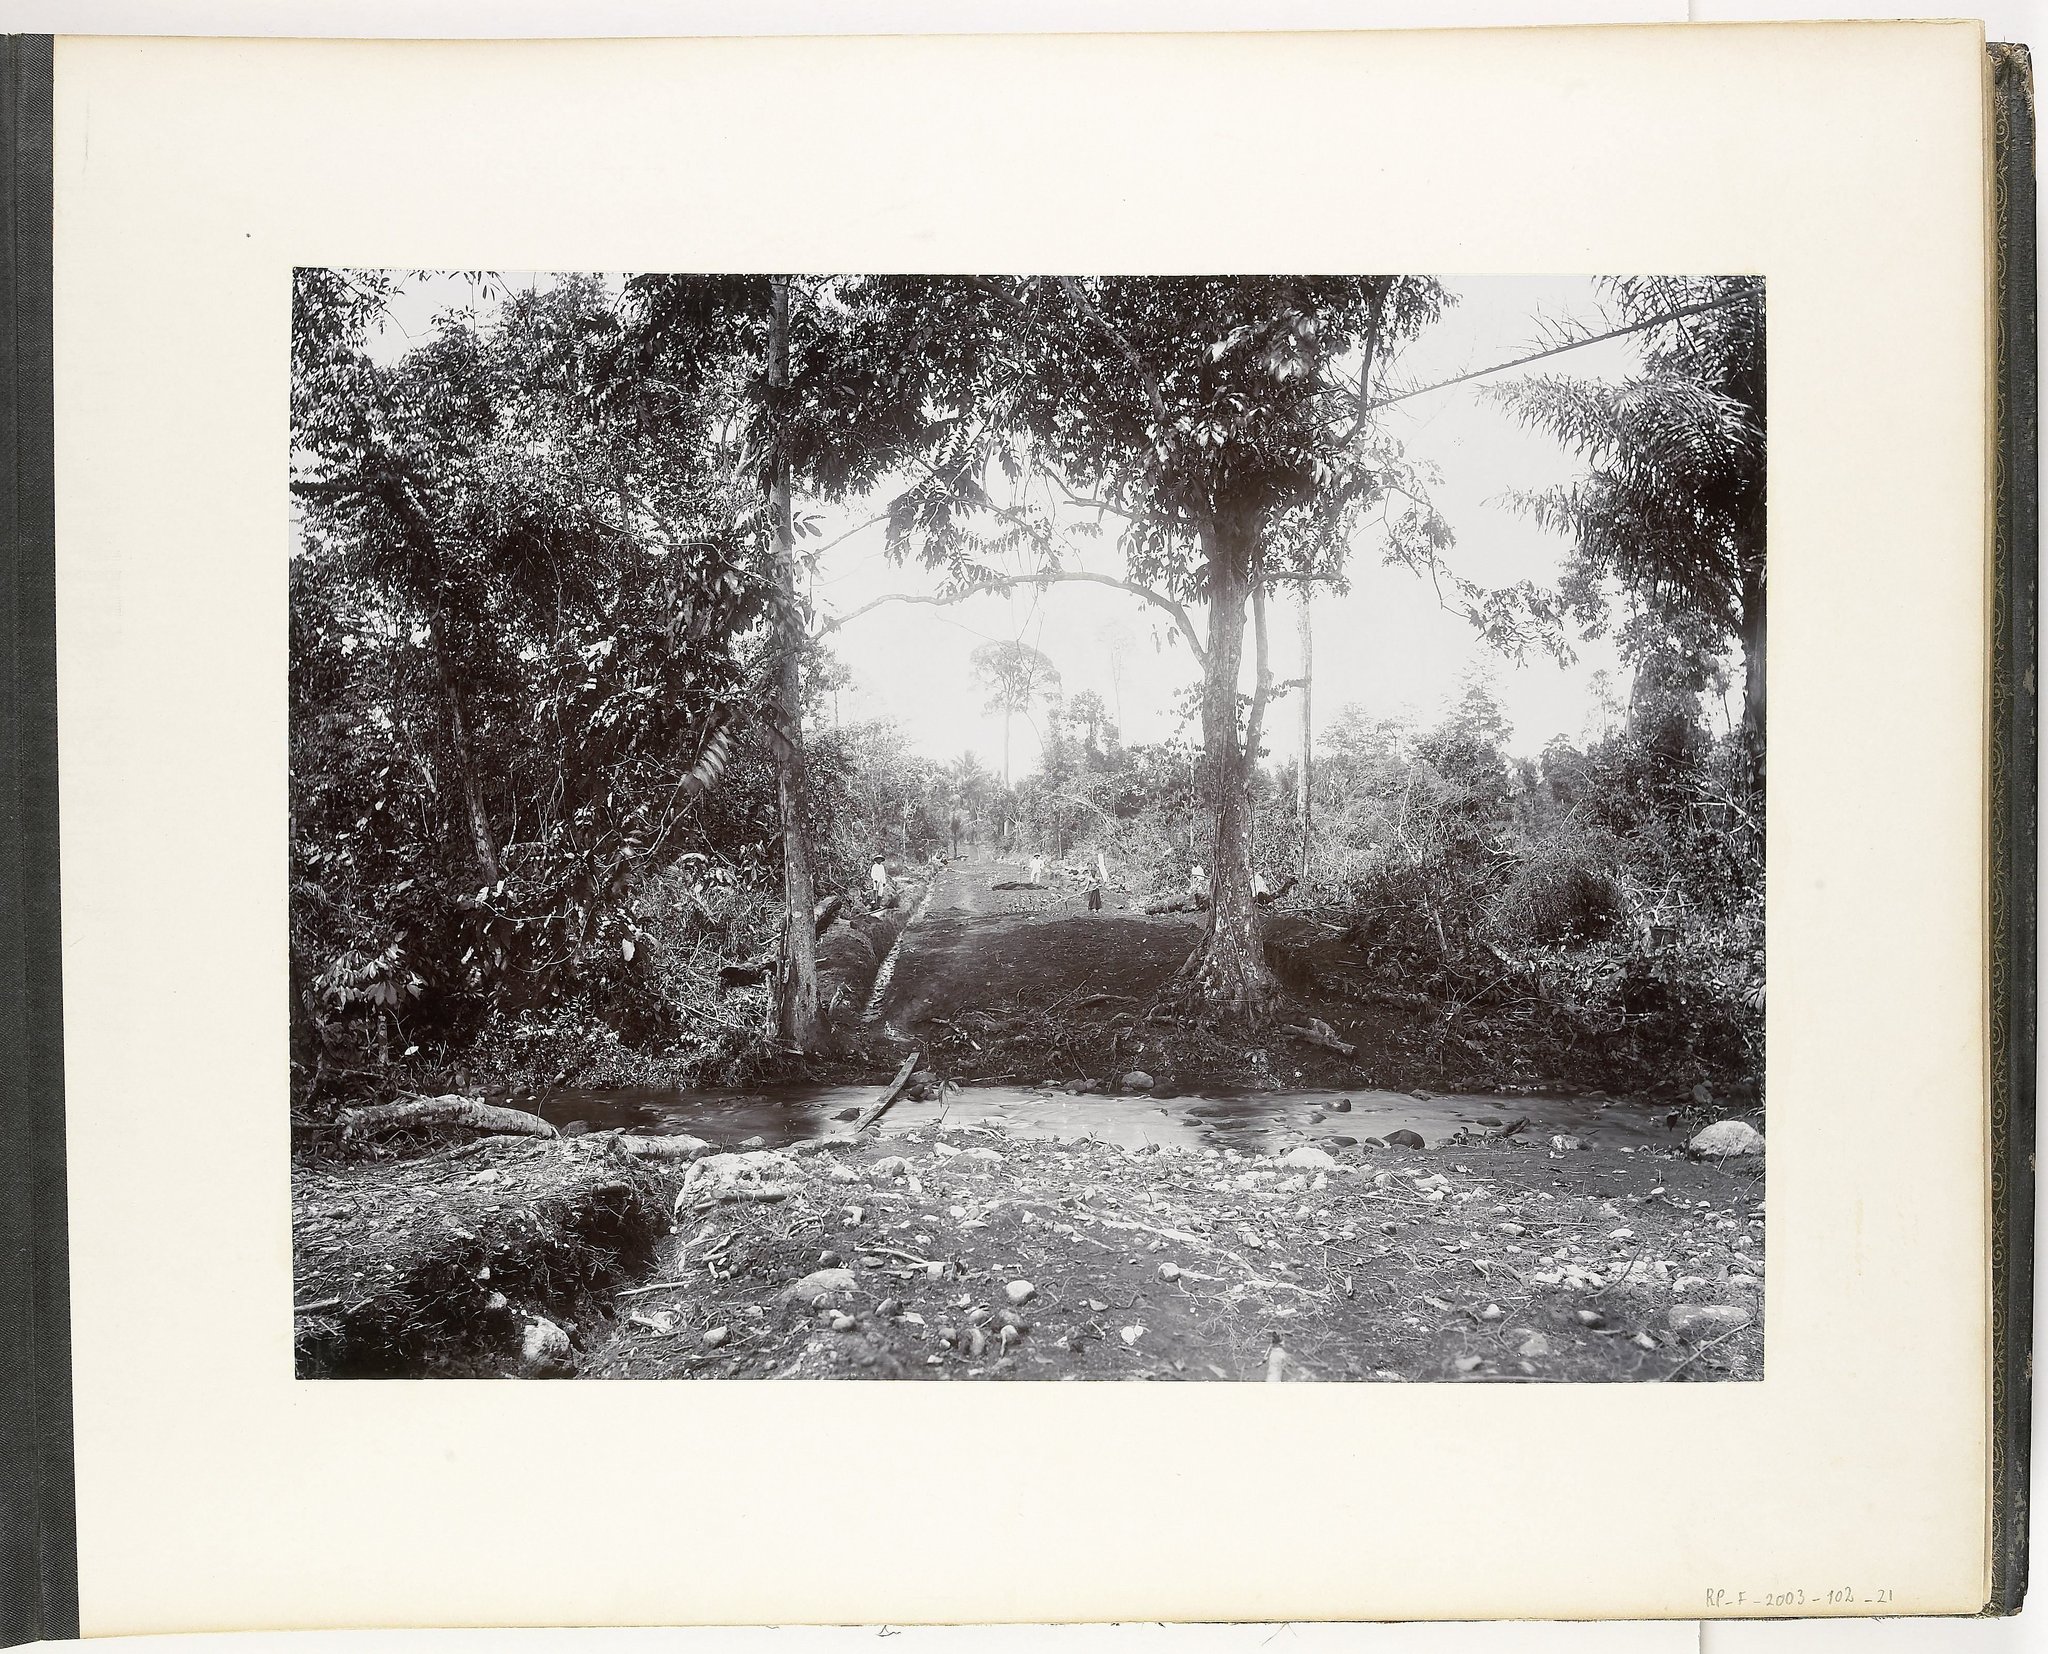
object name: photograph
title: Aanleg van een weg op de Linggah Estate, Sumatra (Weg Linggah Estate)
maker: carl j. kleingrothe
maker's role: fotograaf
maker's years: 1864-1925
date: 1885-1900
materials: photographic support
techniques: collodion silver print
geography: sumatra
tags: sumatra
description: Aanleg van een weg door het woud op de Lingga Plantage op Sumatra. Onderdeel van het Sumatra fotoalbum van Paul en Lucie Sandel uit 1900.